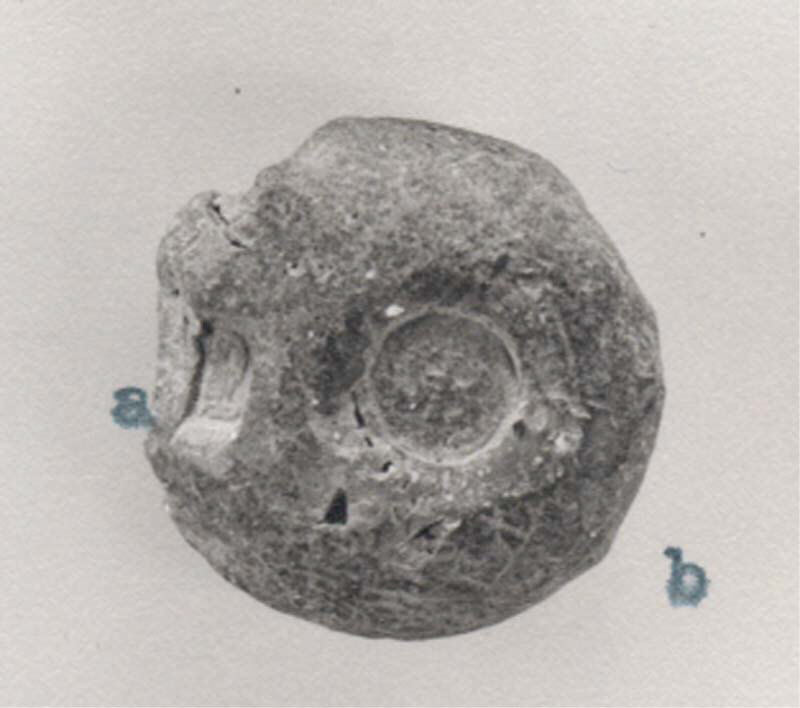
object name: sealing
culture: sasanian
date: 601-700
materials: clay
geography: iran